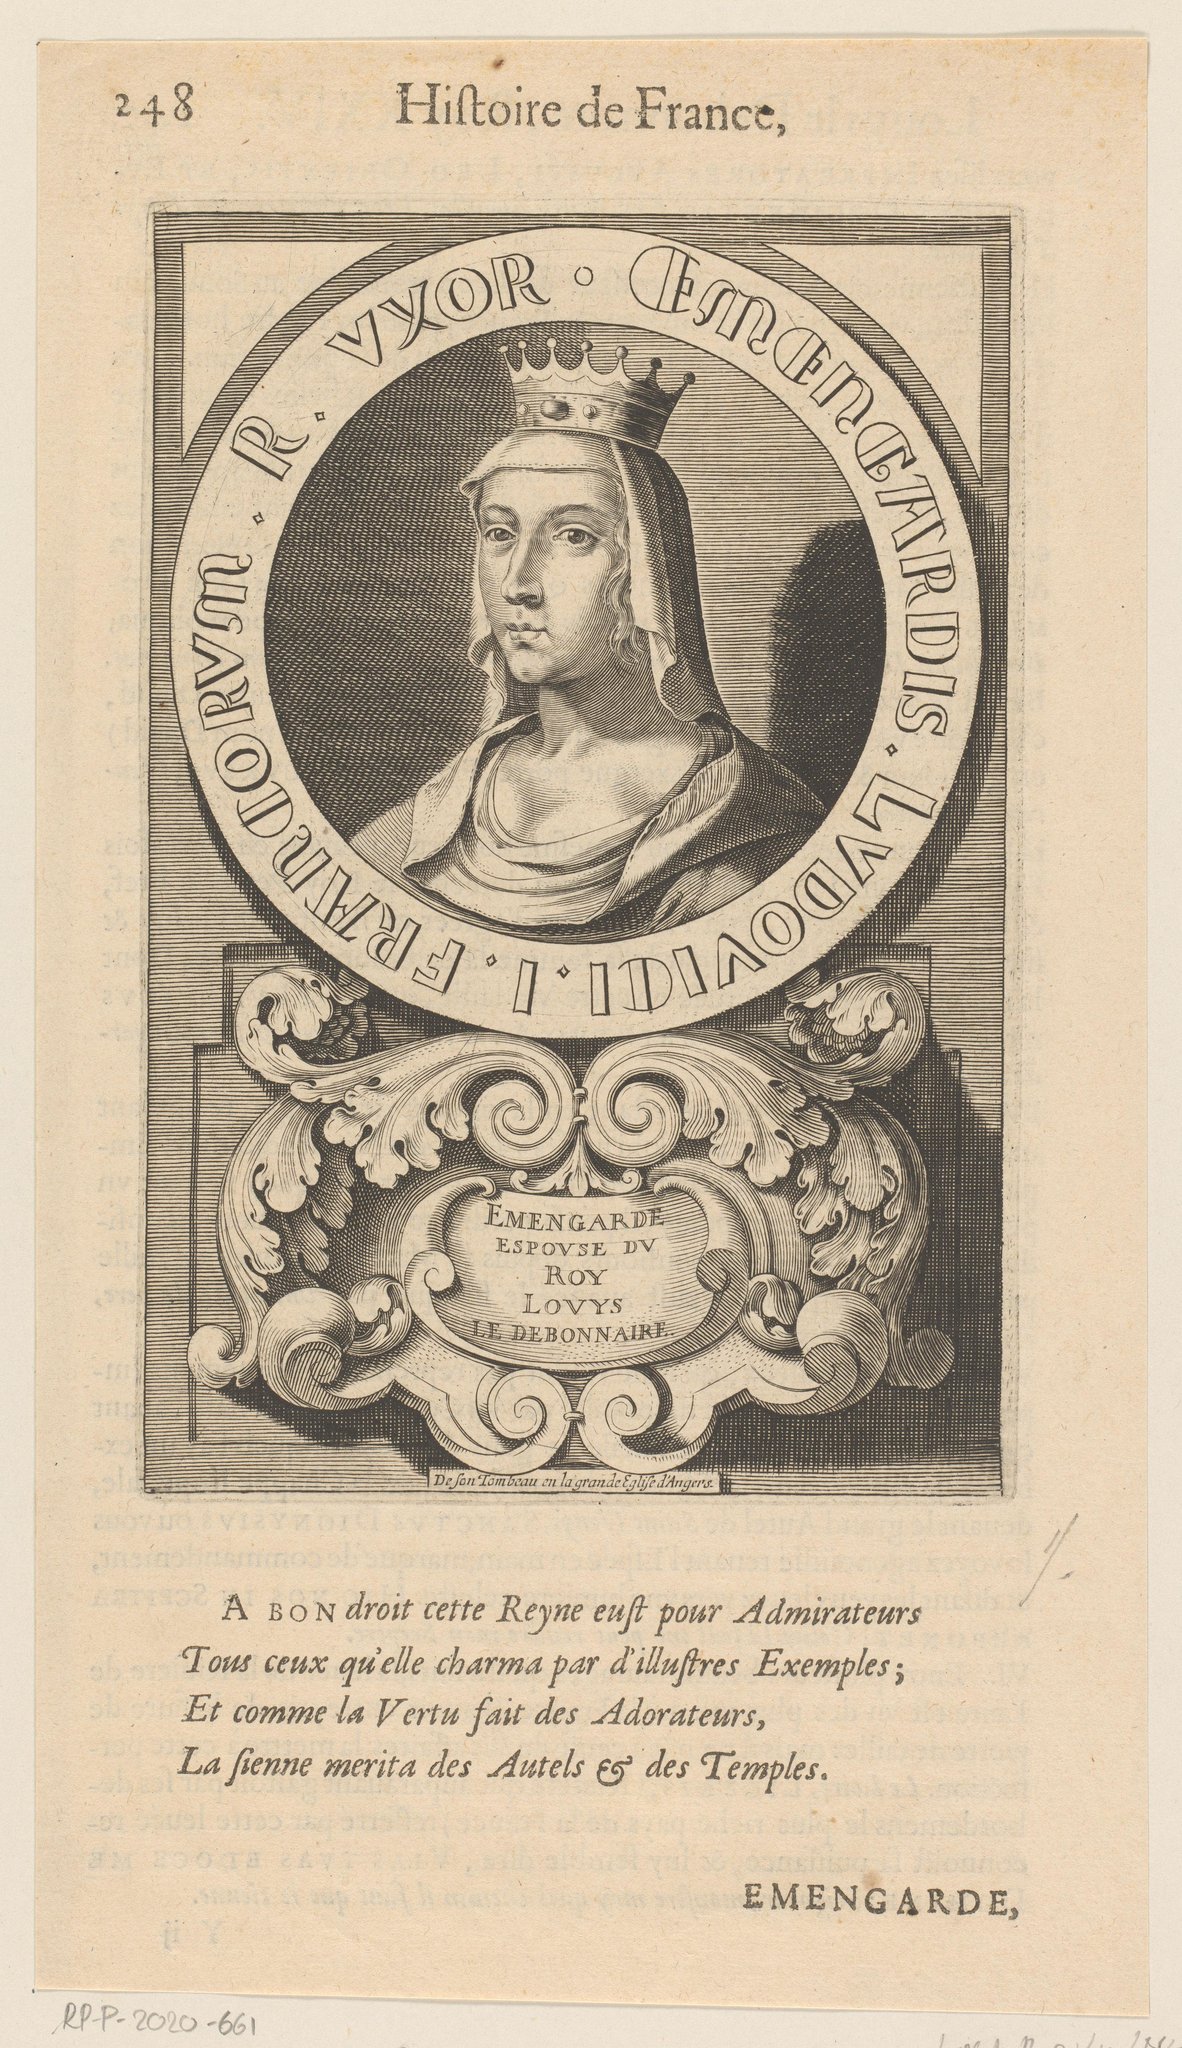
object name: book illustration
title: Portret van Ermengarde van Haspengouw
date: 1643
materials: paper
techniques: engraving, letterpress printing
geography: paris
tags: historical persons, queen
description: Prent uit: Eudes de Mézeray, François. Histoire de France, depuis Faramond jusqu’au regne de Louis le Juste (...). 3 dln. Parijs: Mathieu Guillemot, 1643, dl. 1. Prent waarschijnlijk voor het eerst verschenen in: Bie, Jacques de. Les vrais portraits des rois de France (...). Parijs: Jacques de Bie en Pierre Rocolet, 1634. Prent ook gebruikt in latere publicaties.